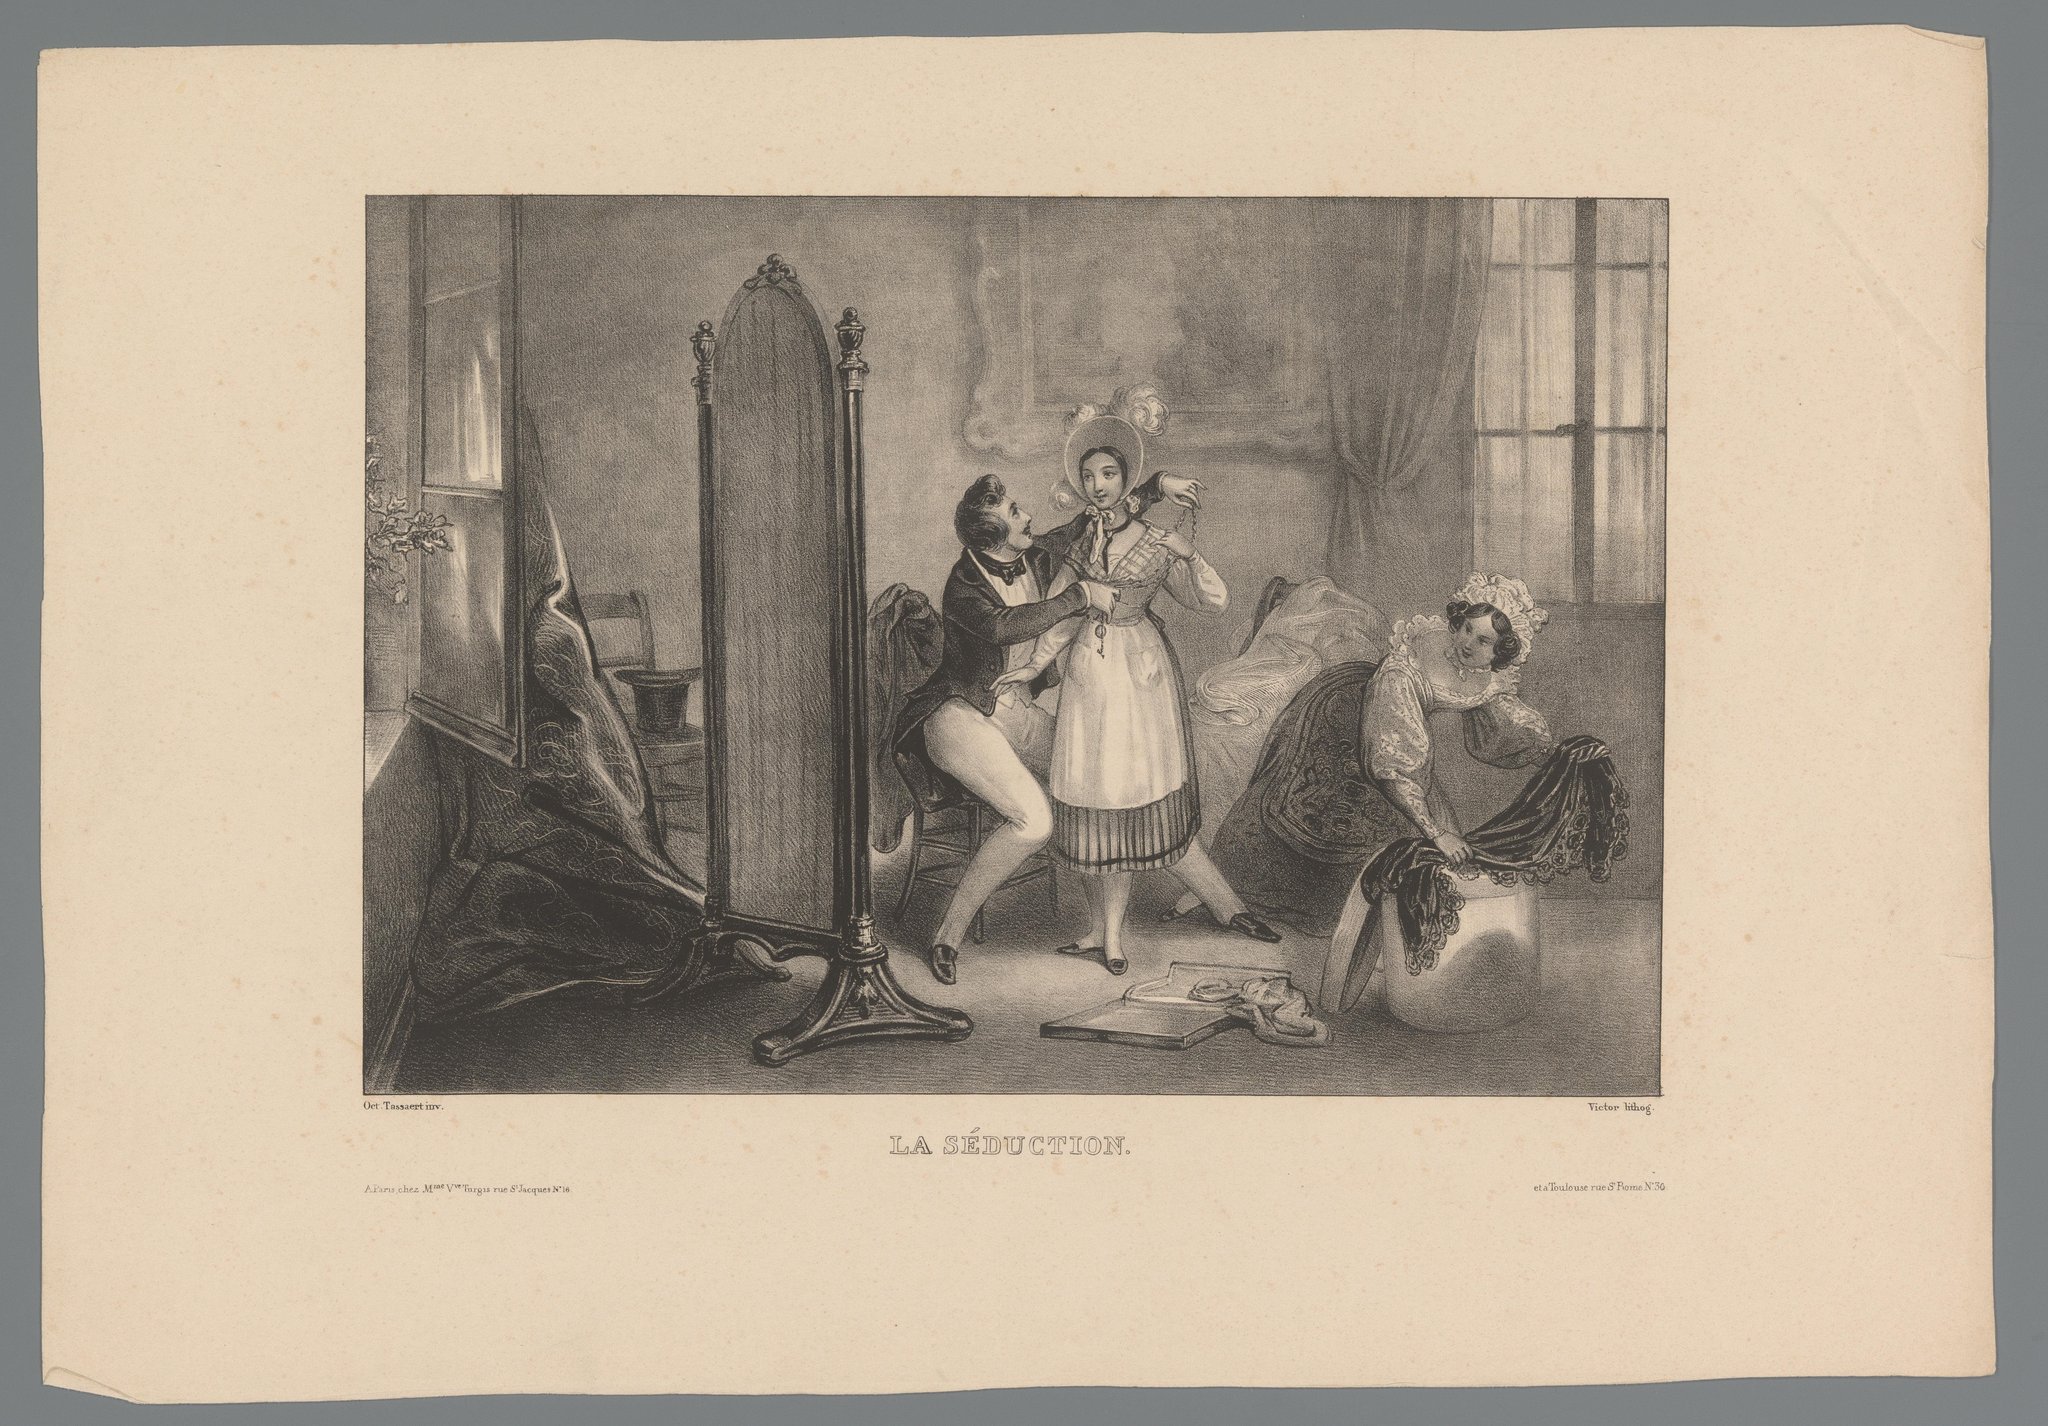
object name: print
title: La séduction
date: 1839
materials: paper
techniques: lithograph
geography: toulouse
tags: clothes for special purposes, courting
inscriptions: collector's mark: Lugt 2228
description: De serie bestaat, zo meldt Béraldi, uit 4 prenten. Dit is prent 3.